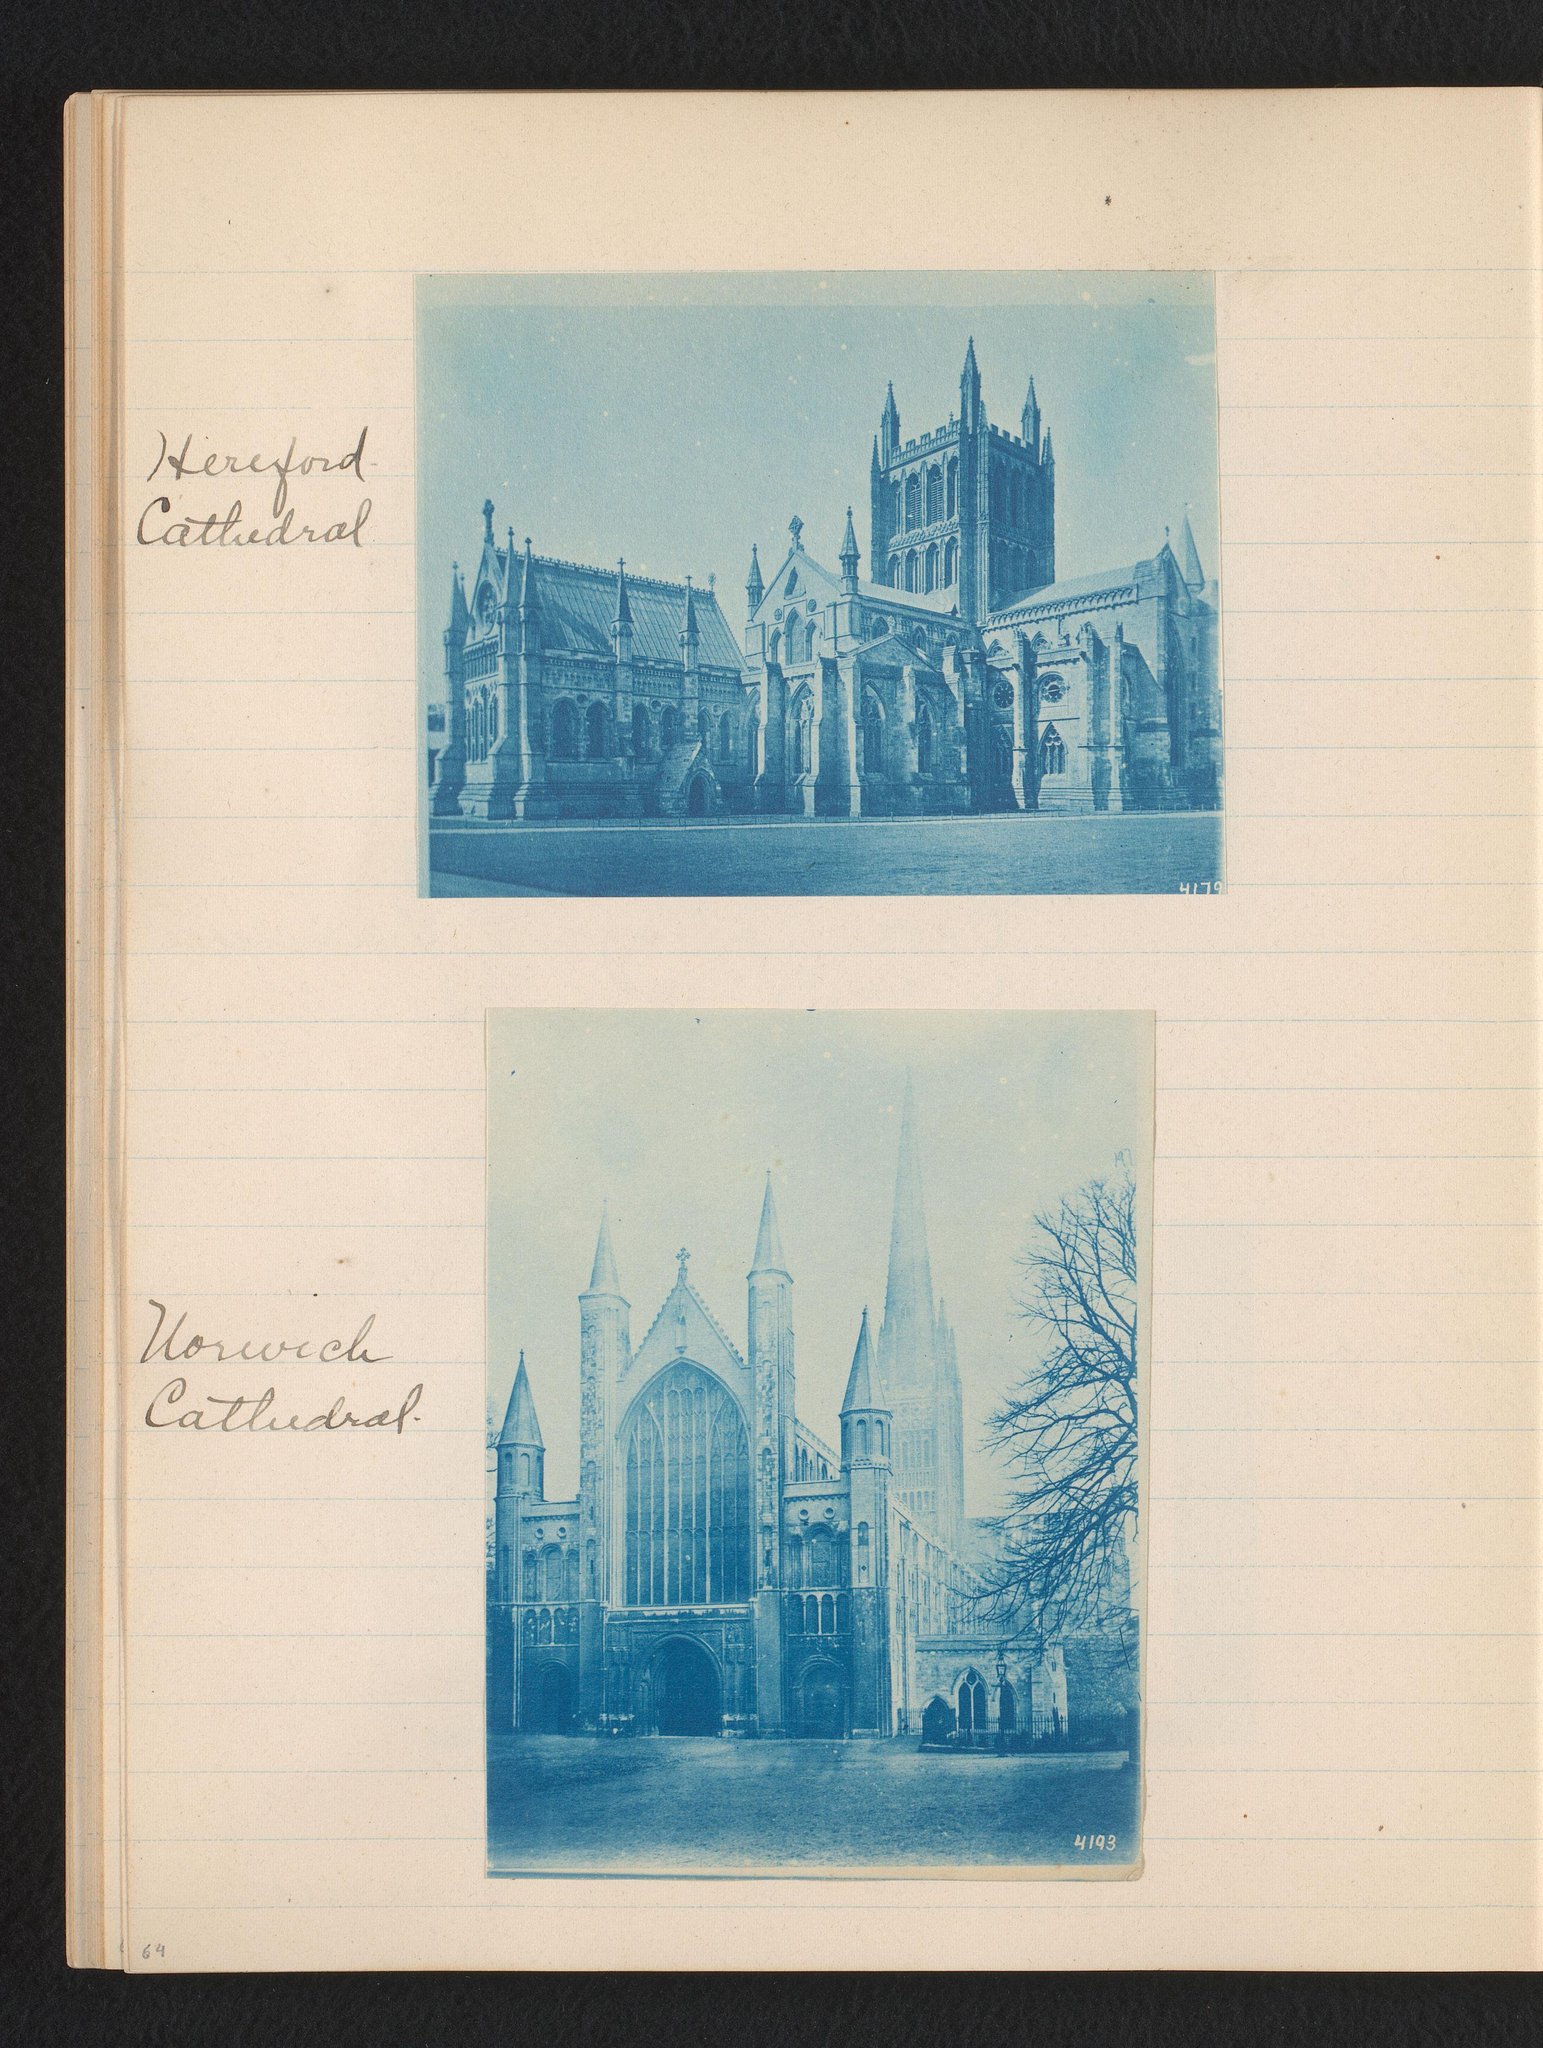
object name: photograph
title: Twee foto's van de kathedralen van Hereford en Norwich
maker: Anonymous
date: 1901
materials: paper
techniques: cyanotype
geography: england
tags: church (exterior)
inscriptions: inscription: ‘Hereford/ Cathedral./ Norwich/ Cathedral.’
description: Deze foto's maken deel uit van een album.